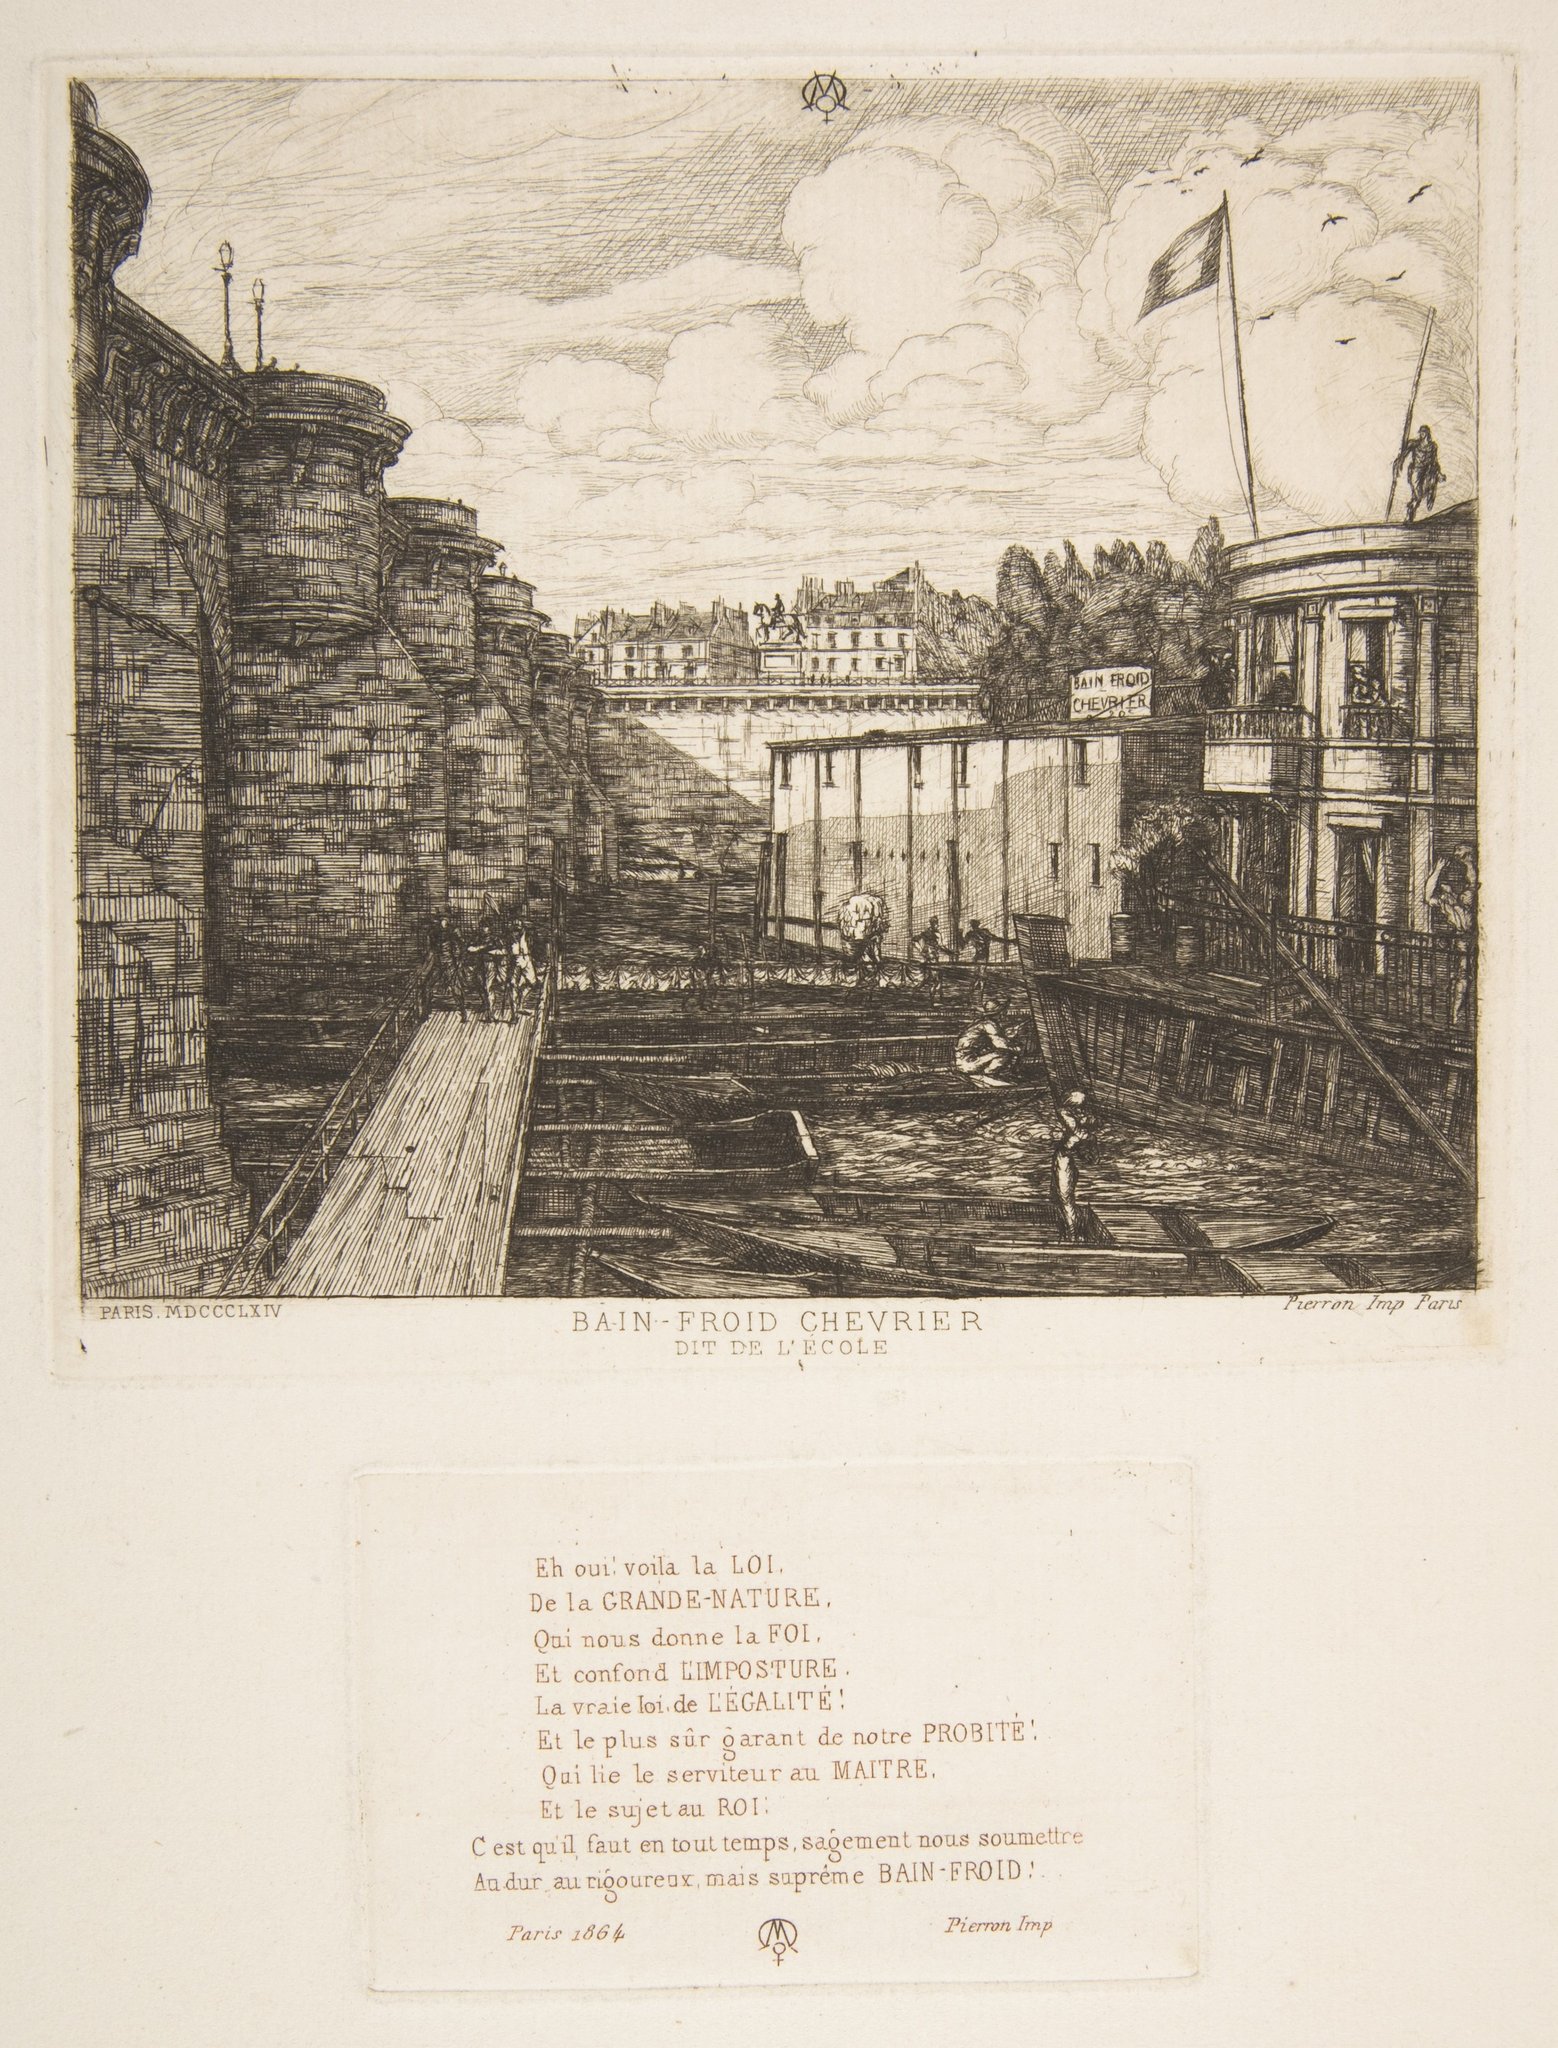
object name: print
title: Bain-froid Chevrier (Chevrier's cold bath establishment, or The School Baths, Paris)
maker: charles meryon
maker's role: artist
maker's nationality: french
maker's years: 1821-1868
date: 1864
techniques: etching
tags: buildings,boats,paris